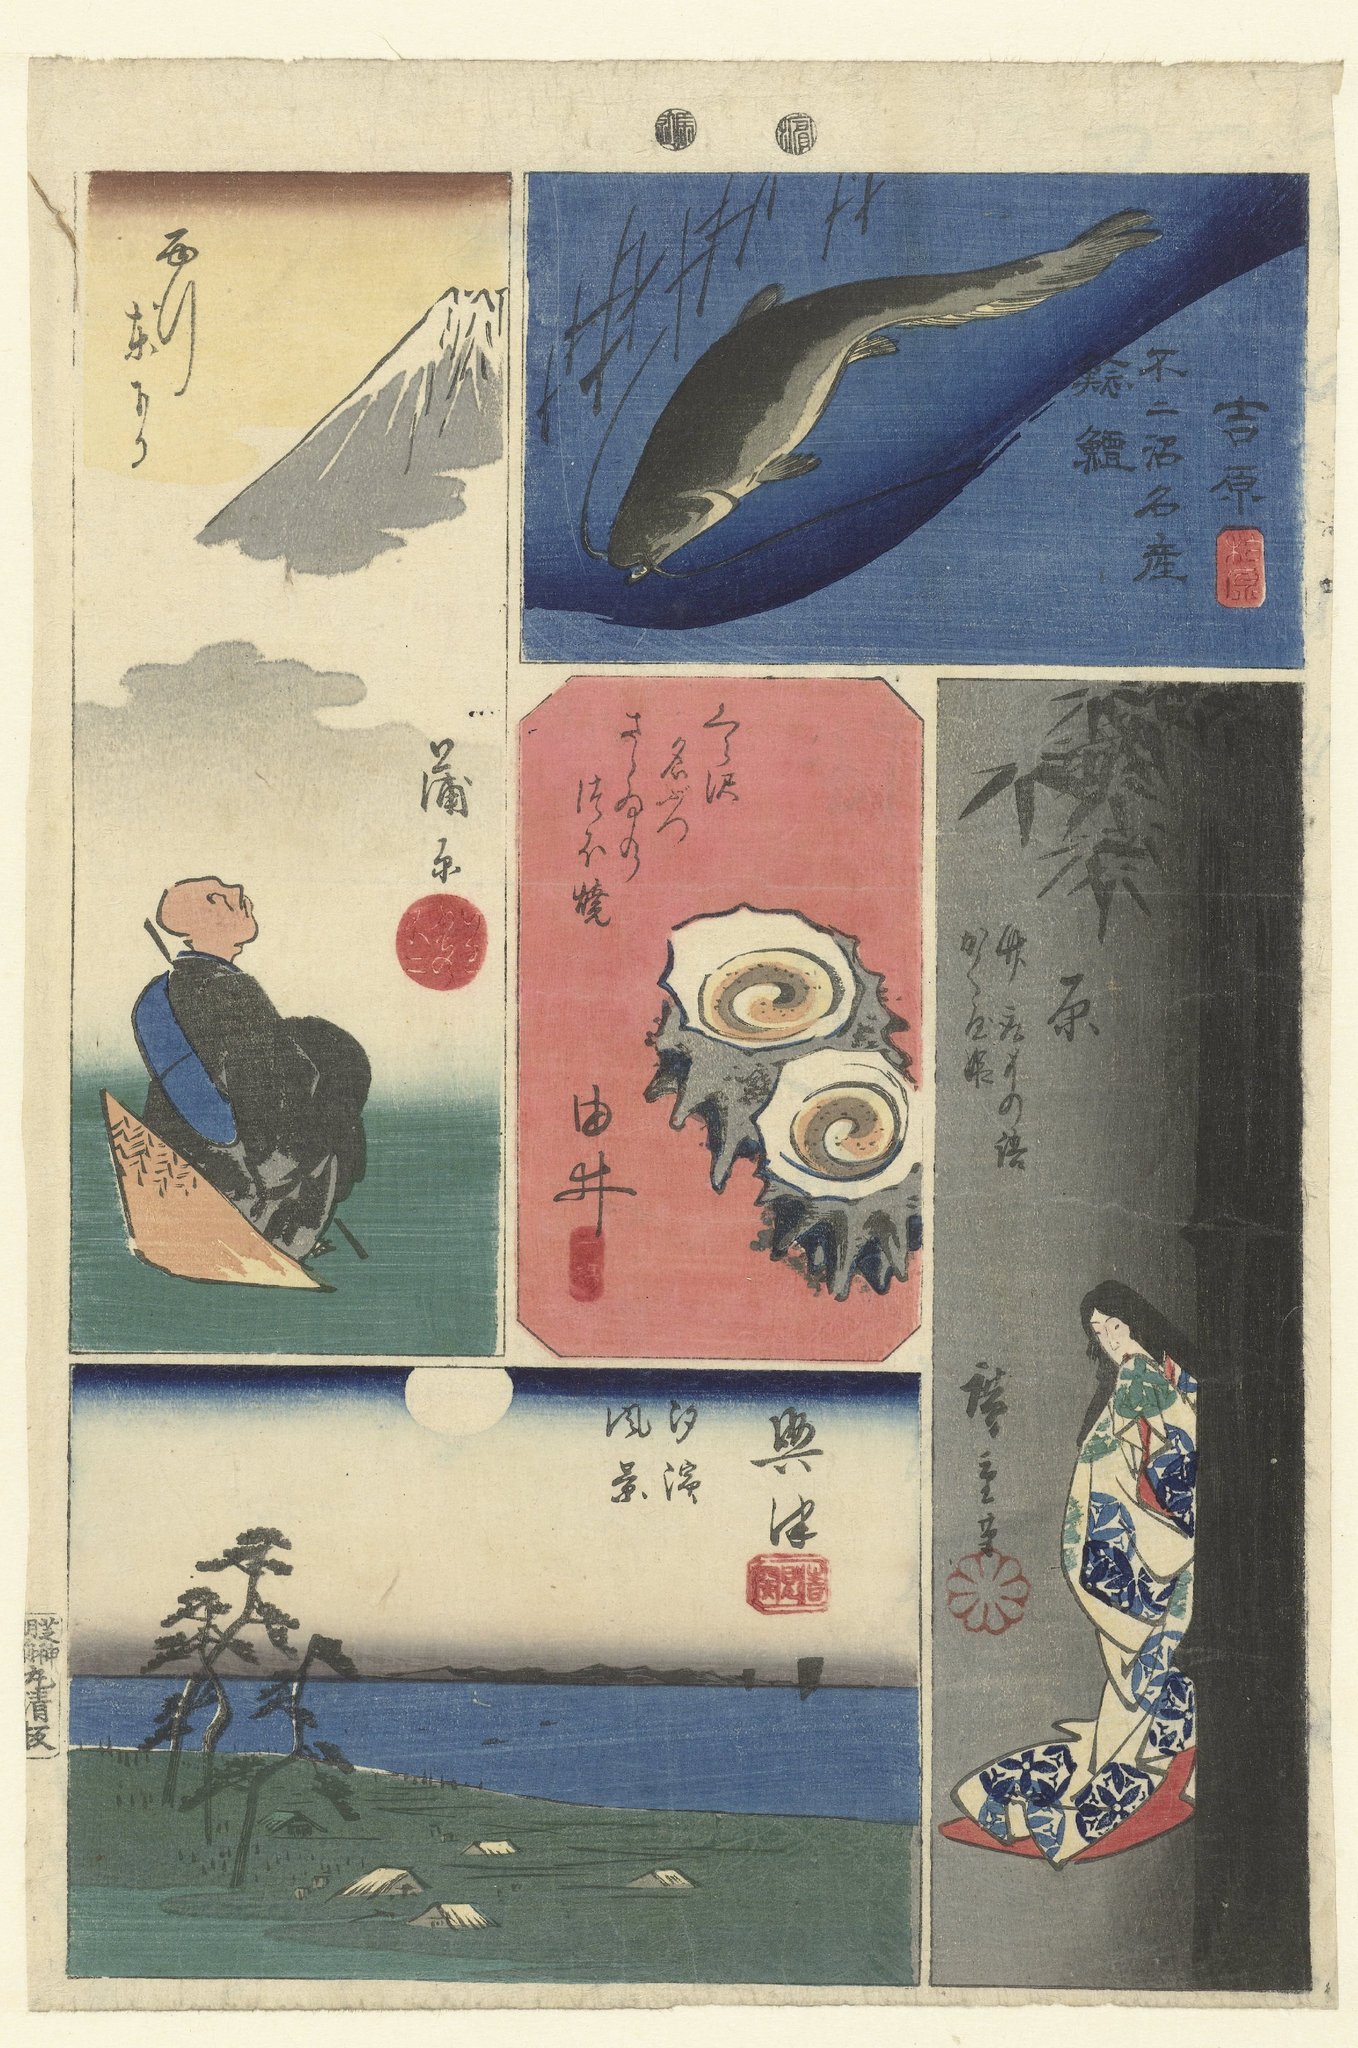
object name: print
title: Nummer vier van de Tokaido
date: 1849-1850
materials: paper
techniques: woodcut, nishiki e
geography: japan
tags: man in a general biological sense, landscapes, fishes